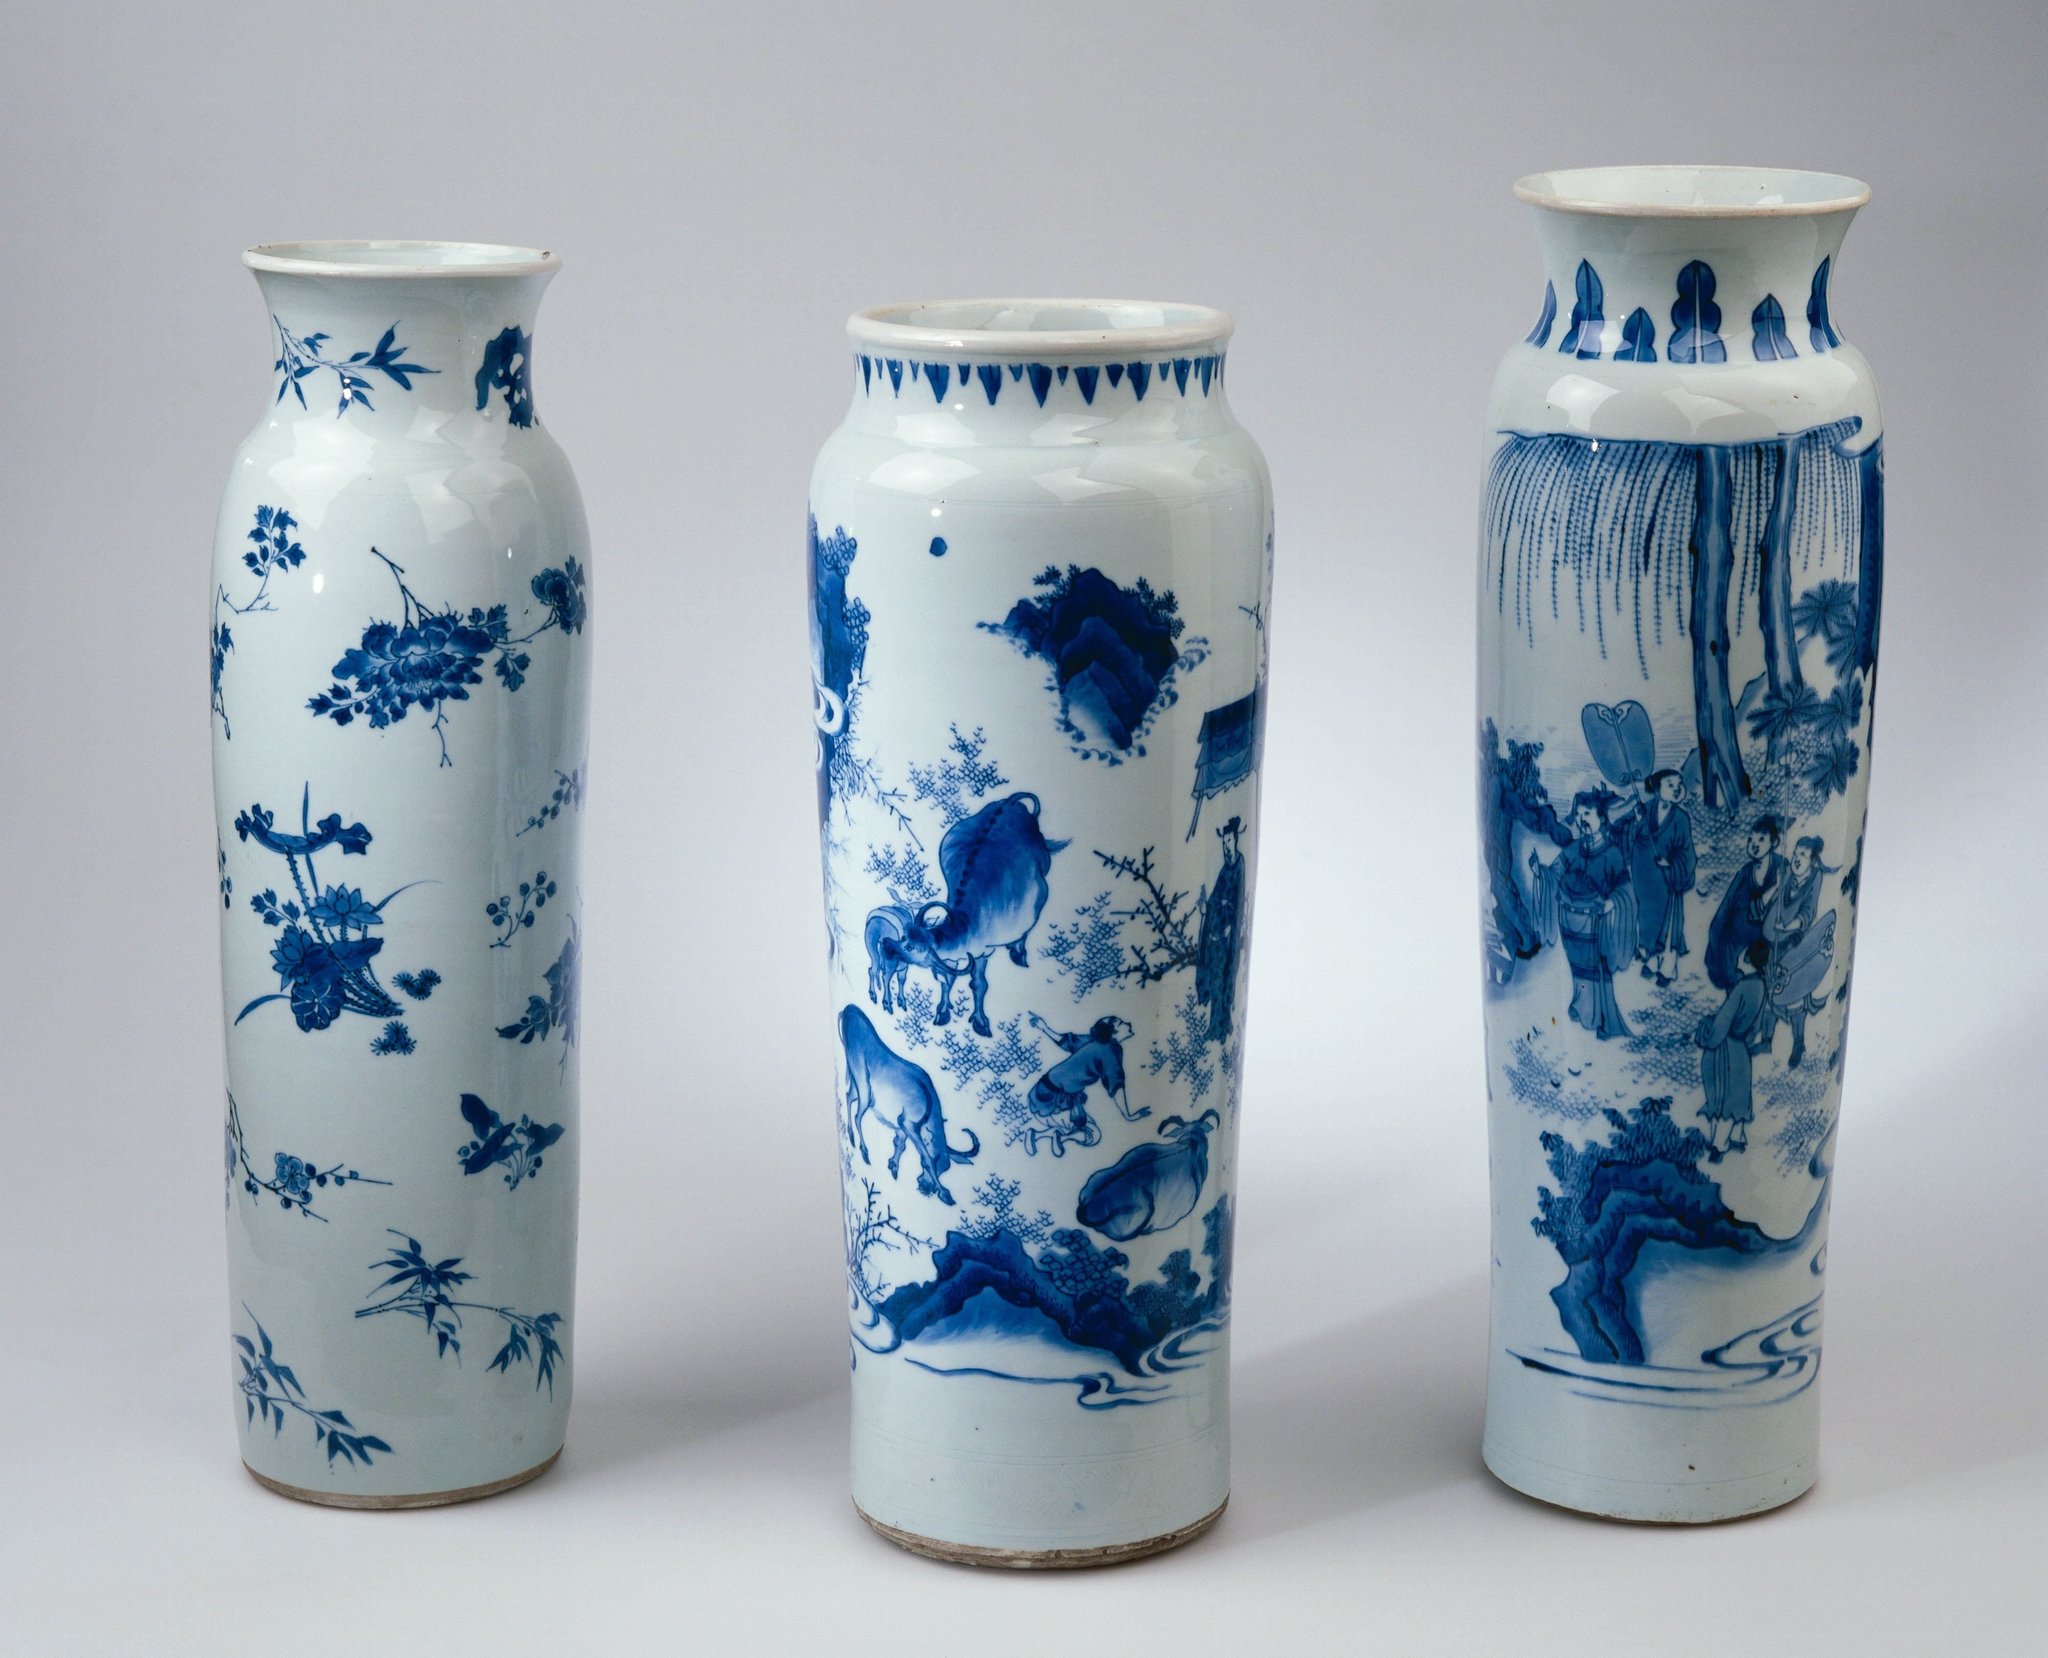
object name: vase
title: Vase (rolwagen) with flower sprays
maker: Anonymous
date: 1635-1650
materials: cobalt, glaze, paint, porcelain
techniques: firing, turning, vitrification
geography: china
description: AK-NM-6685 Rolwagen • Overgangsporselein • Onderdeel van Royers porseleincollectie • Rolwagen • Op de bodem in bruine inkt: ‘SA’ • Met dank aan Fan Lin, Qinxin He and Erika Riccobon, Universiteit Leiden, voor informatie over de voorstelling De inscriptie ‘SA’ staat waarschijnlijk voor Son Altesse. Zie hiervoor de toelichting bij AK-NM-6675. Ook AK-NM-6677 heeft deze inscriptie. De bloemtakken zijn fraai geschilderd. Het motief komt voor op een groot aantal vazen in de Hatcher cargo, een schip beladen met porselein dat in 1643 zonk [Sheaf en Kilburn 1988]. Een vergelijkbaar exemplaar bevindt zich in de oude collectie van de keurvorsten van Hessen-Kassel [Porzellan aus China und Japan 1990, nr. 37a/b] Bronnen: Colin Sheaf en Richard Kilburn, The Hatcher porcelain cargoes: the complete record, Oxford 1988. Porzellan aus China und Japan: die Porzellangalerie der Landgrafen von Hessen-Kassel, Berlijn 1990.